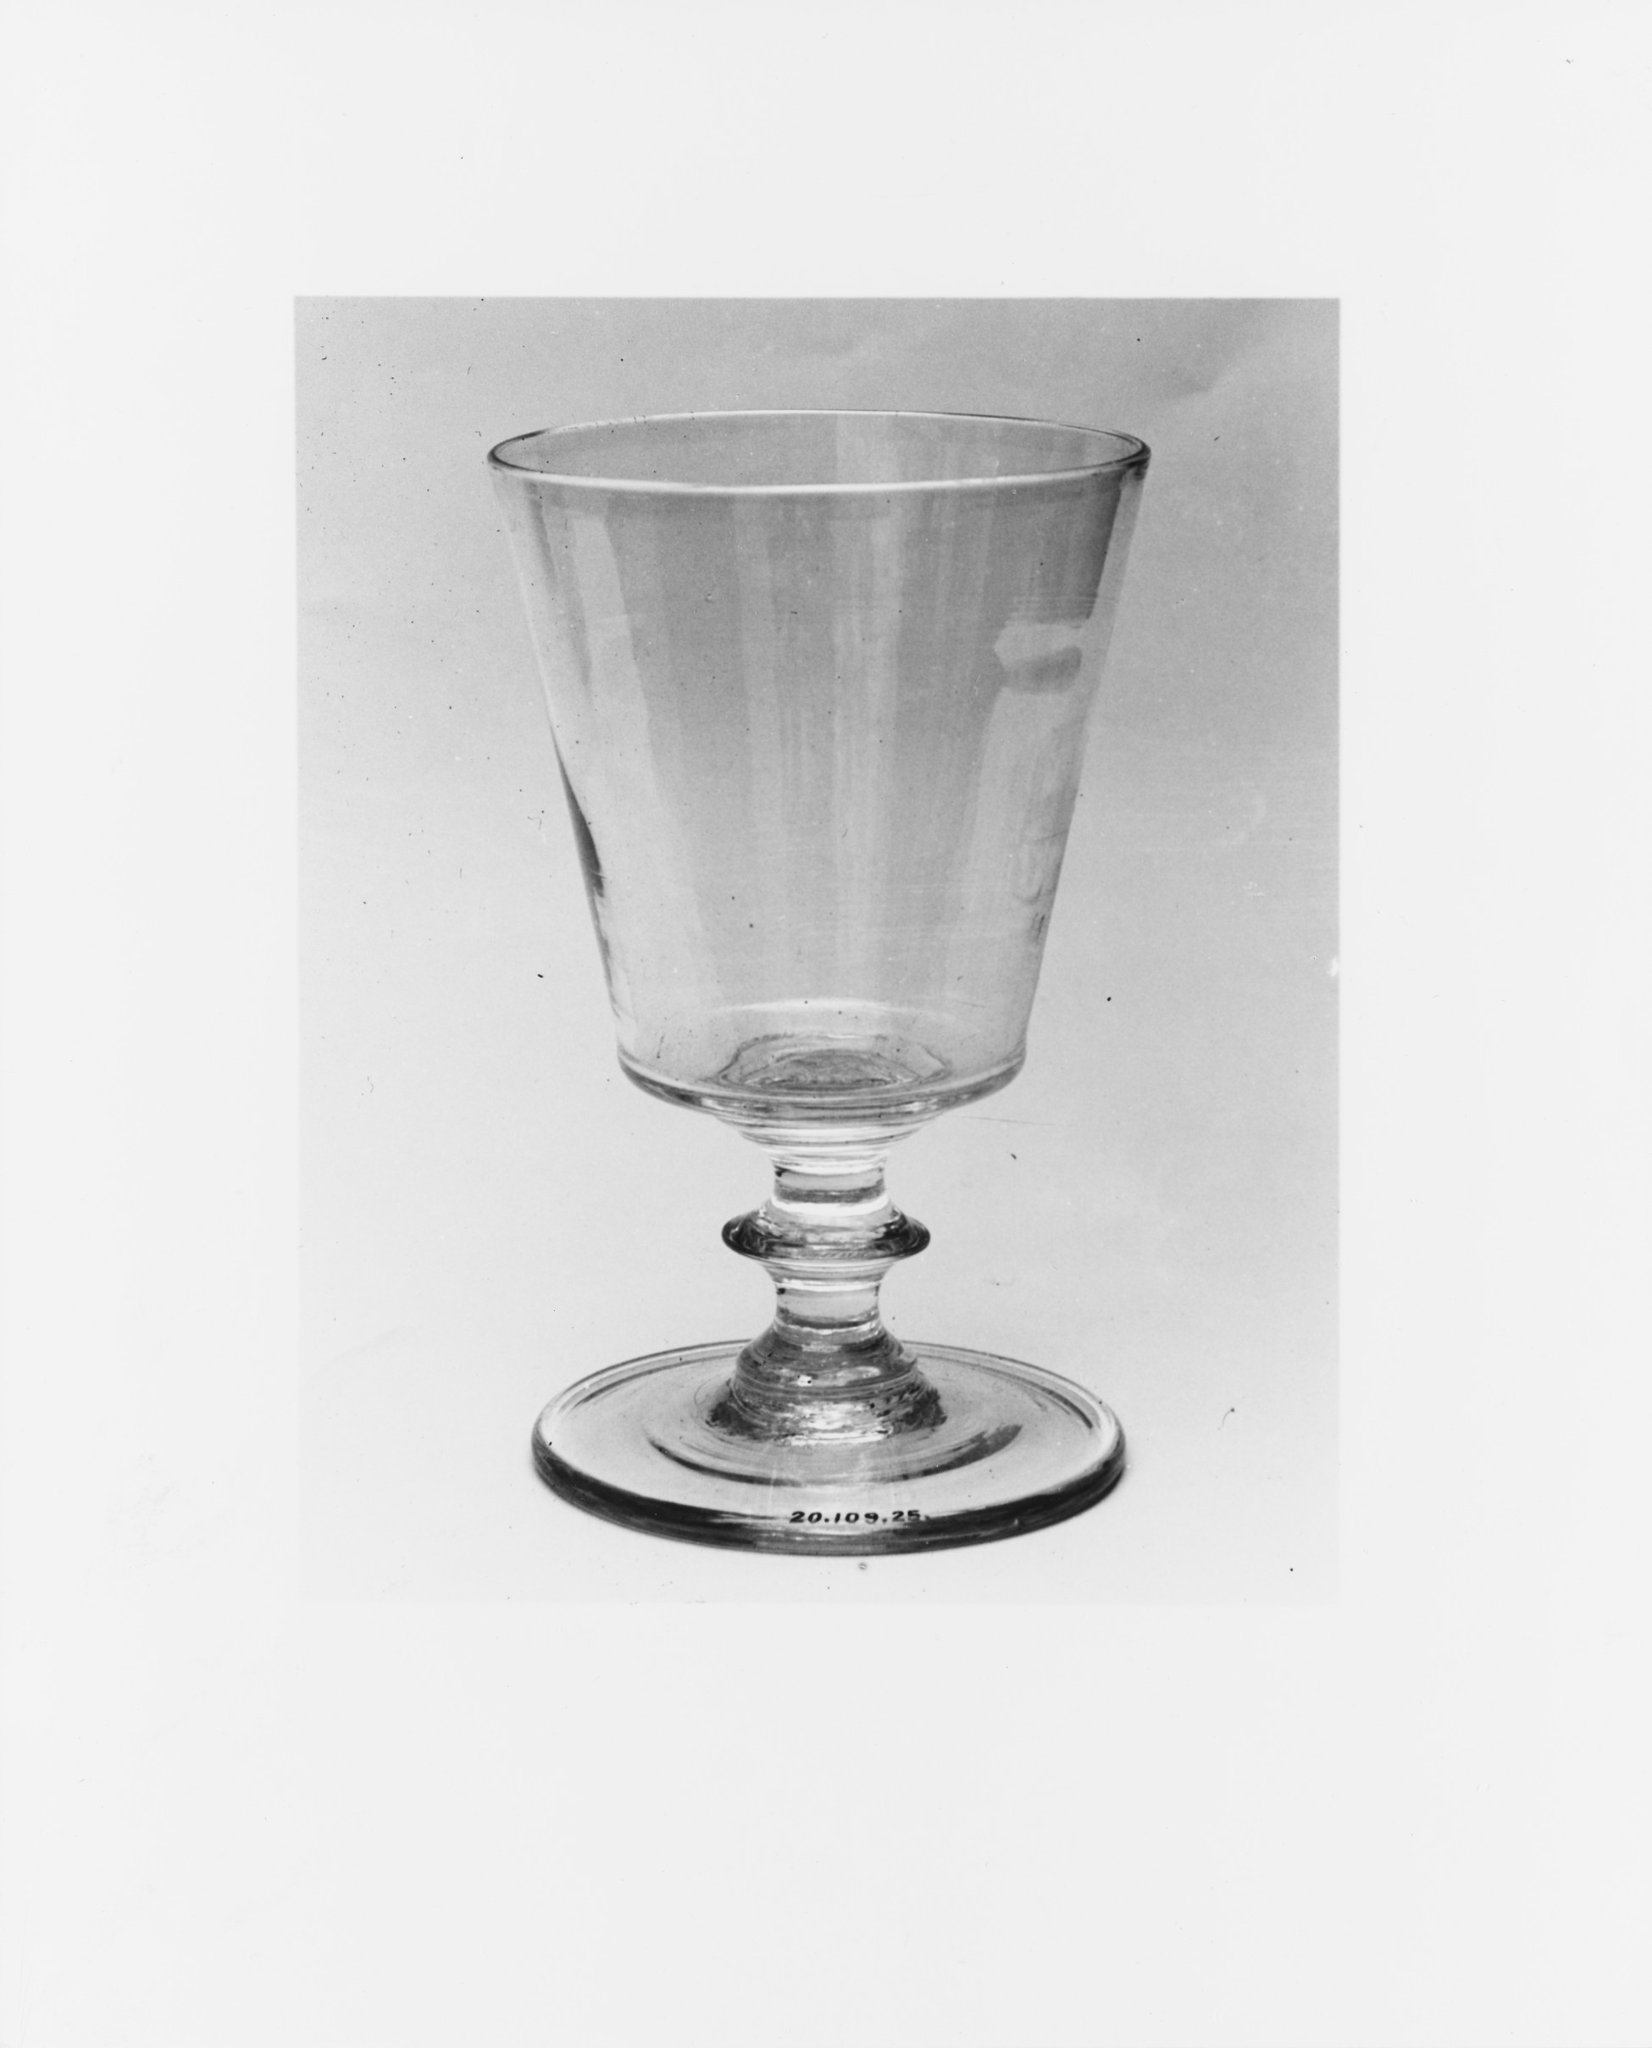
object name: goblet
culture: american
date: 1800-1830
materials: glass, lead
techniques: glassblowing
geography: mid-atlantic